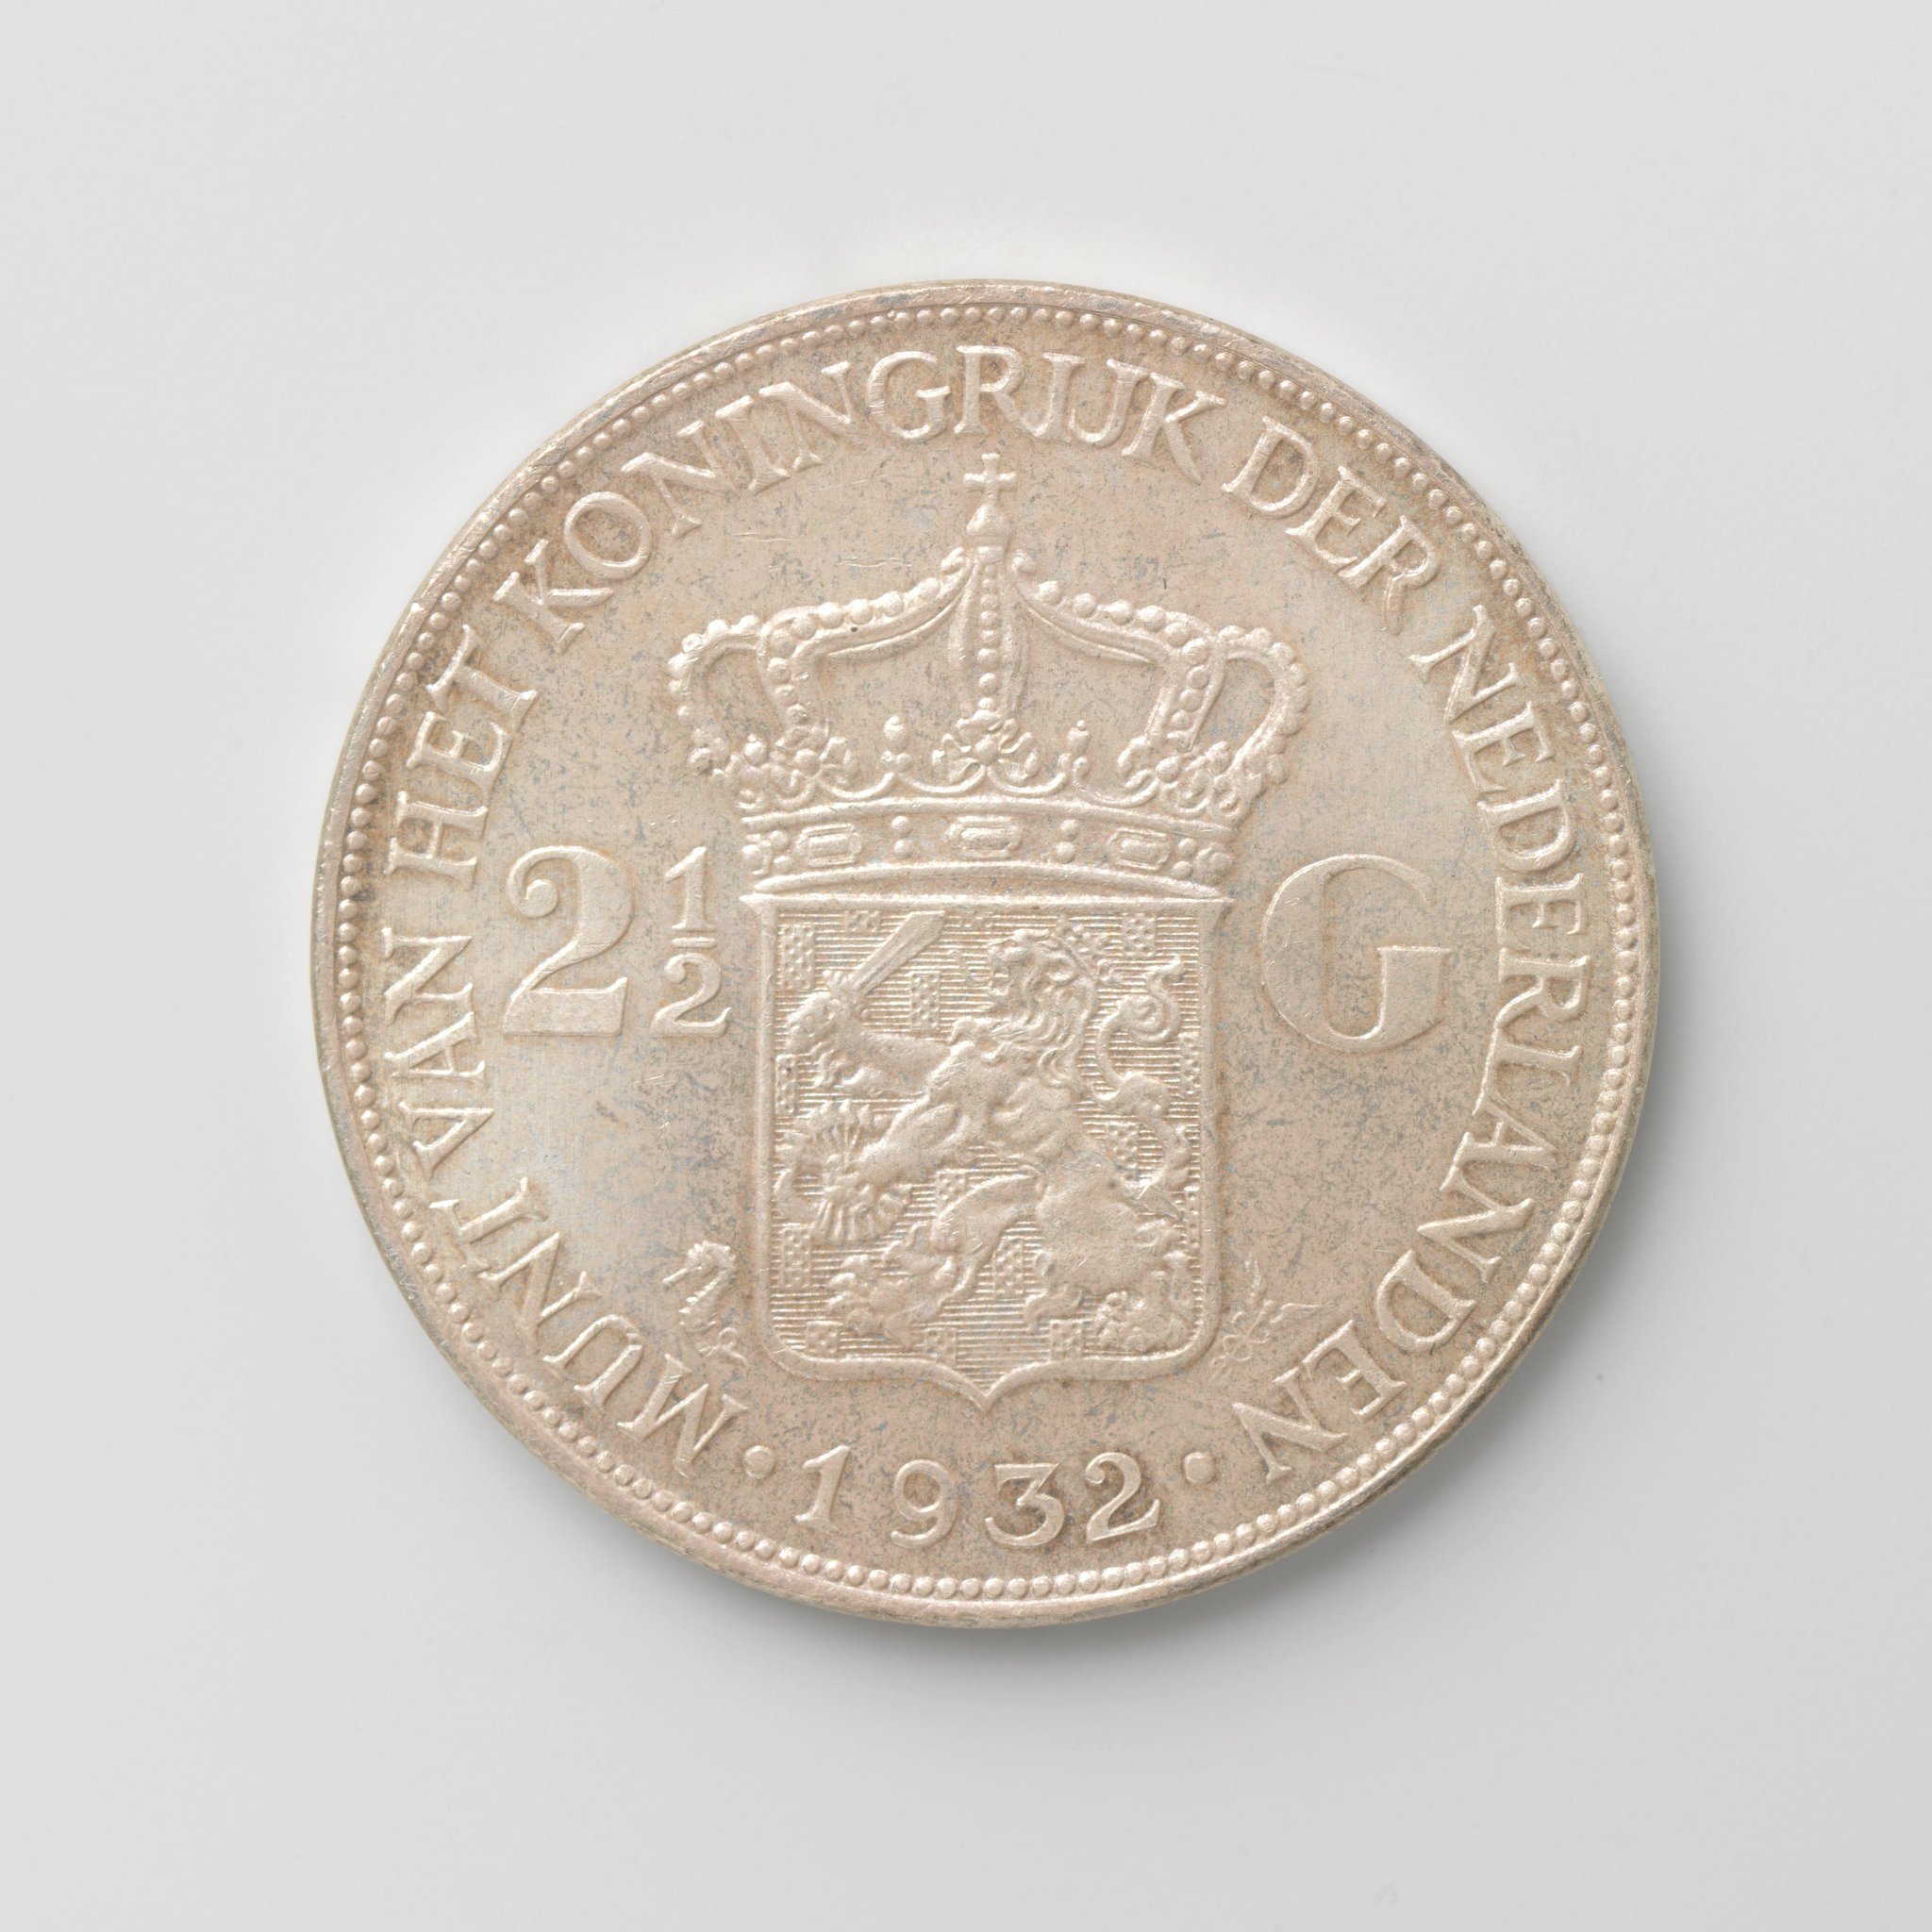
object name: coin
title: Nederlandse 2½ gulden,1932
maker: wilhelmina of the netherlands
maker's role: print maker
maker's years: 1880-1962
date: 1932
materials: silver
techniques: striking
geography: utrecht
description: Zilveren munt. Voorzijde: hoofd naar links. Keerzijde: tussen waarde-aanduiding 2½ G gekroond rijkswapenschild. Jaartal onderaan in omschrift. Randschrift.